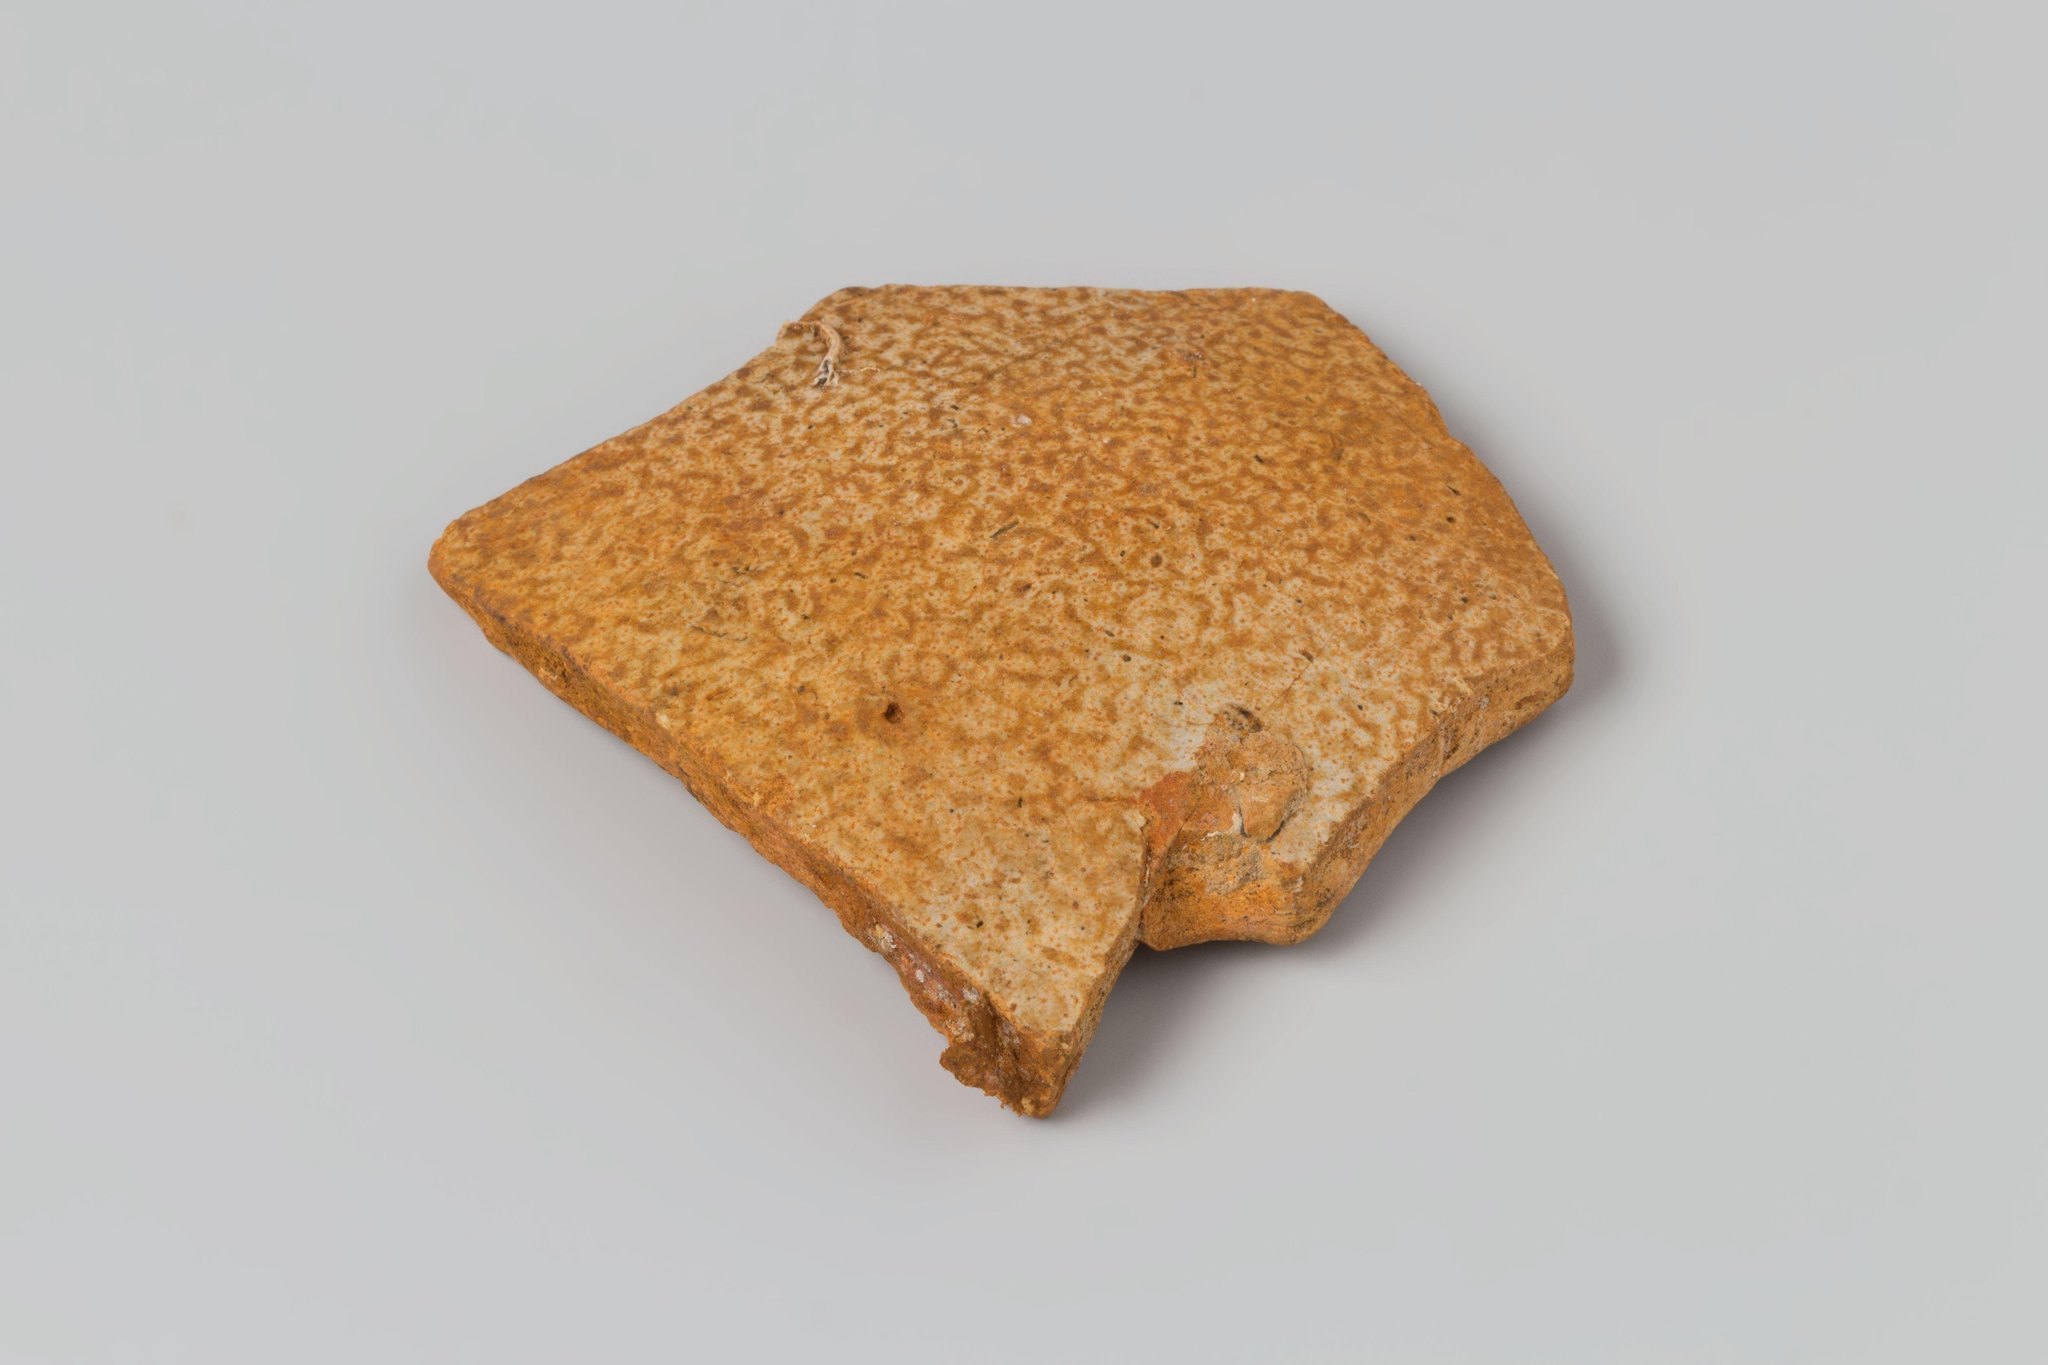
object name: ewer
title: Scherf van een kan uit het wrak van de Oost-Indiëvaarder Hollandia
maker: Anonymous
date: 1700-1743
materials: stoneware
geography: cologne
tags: verenigde oostindische compagnie, hollandia (schip), annet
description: Stoneware, Rhenish, Frechen-ware, jug; fragm of body.